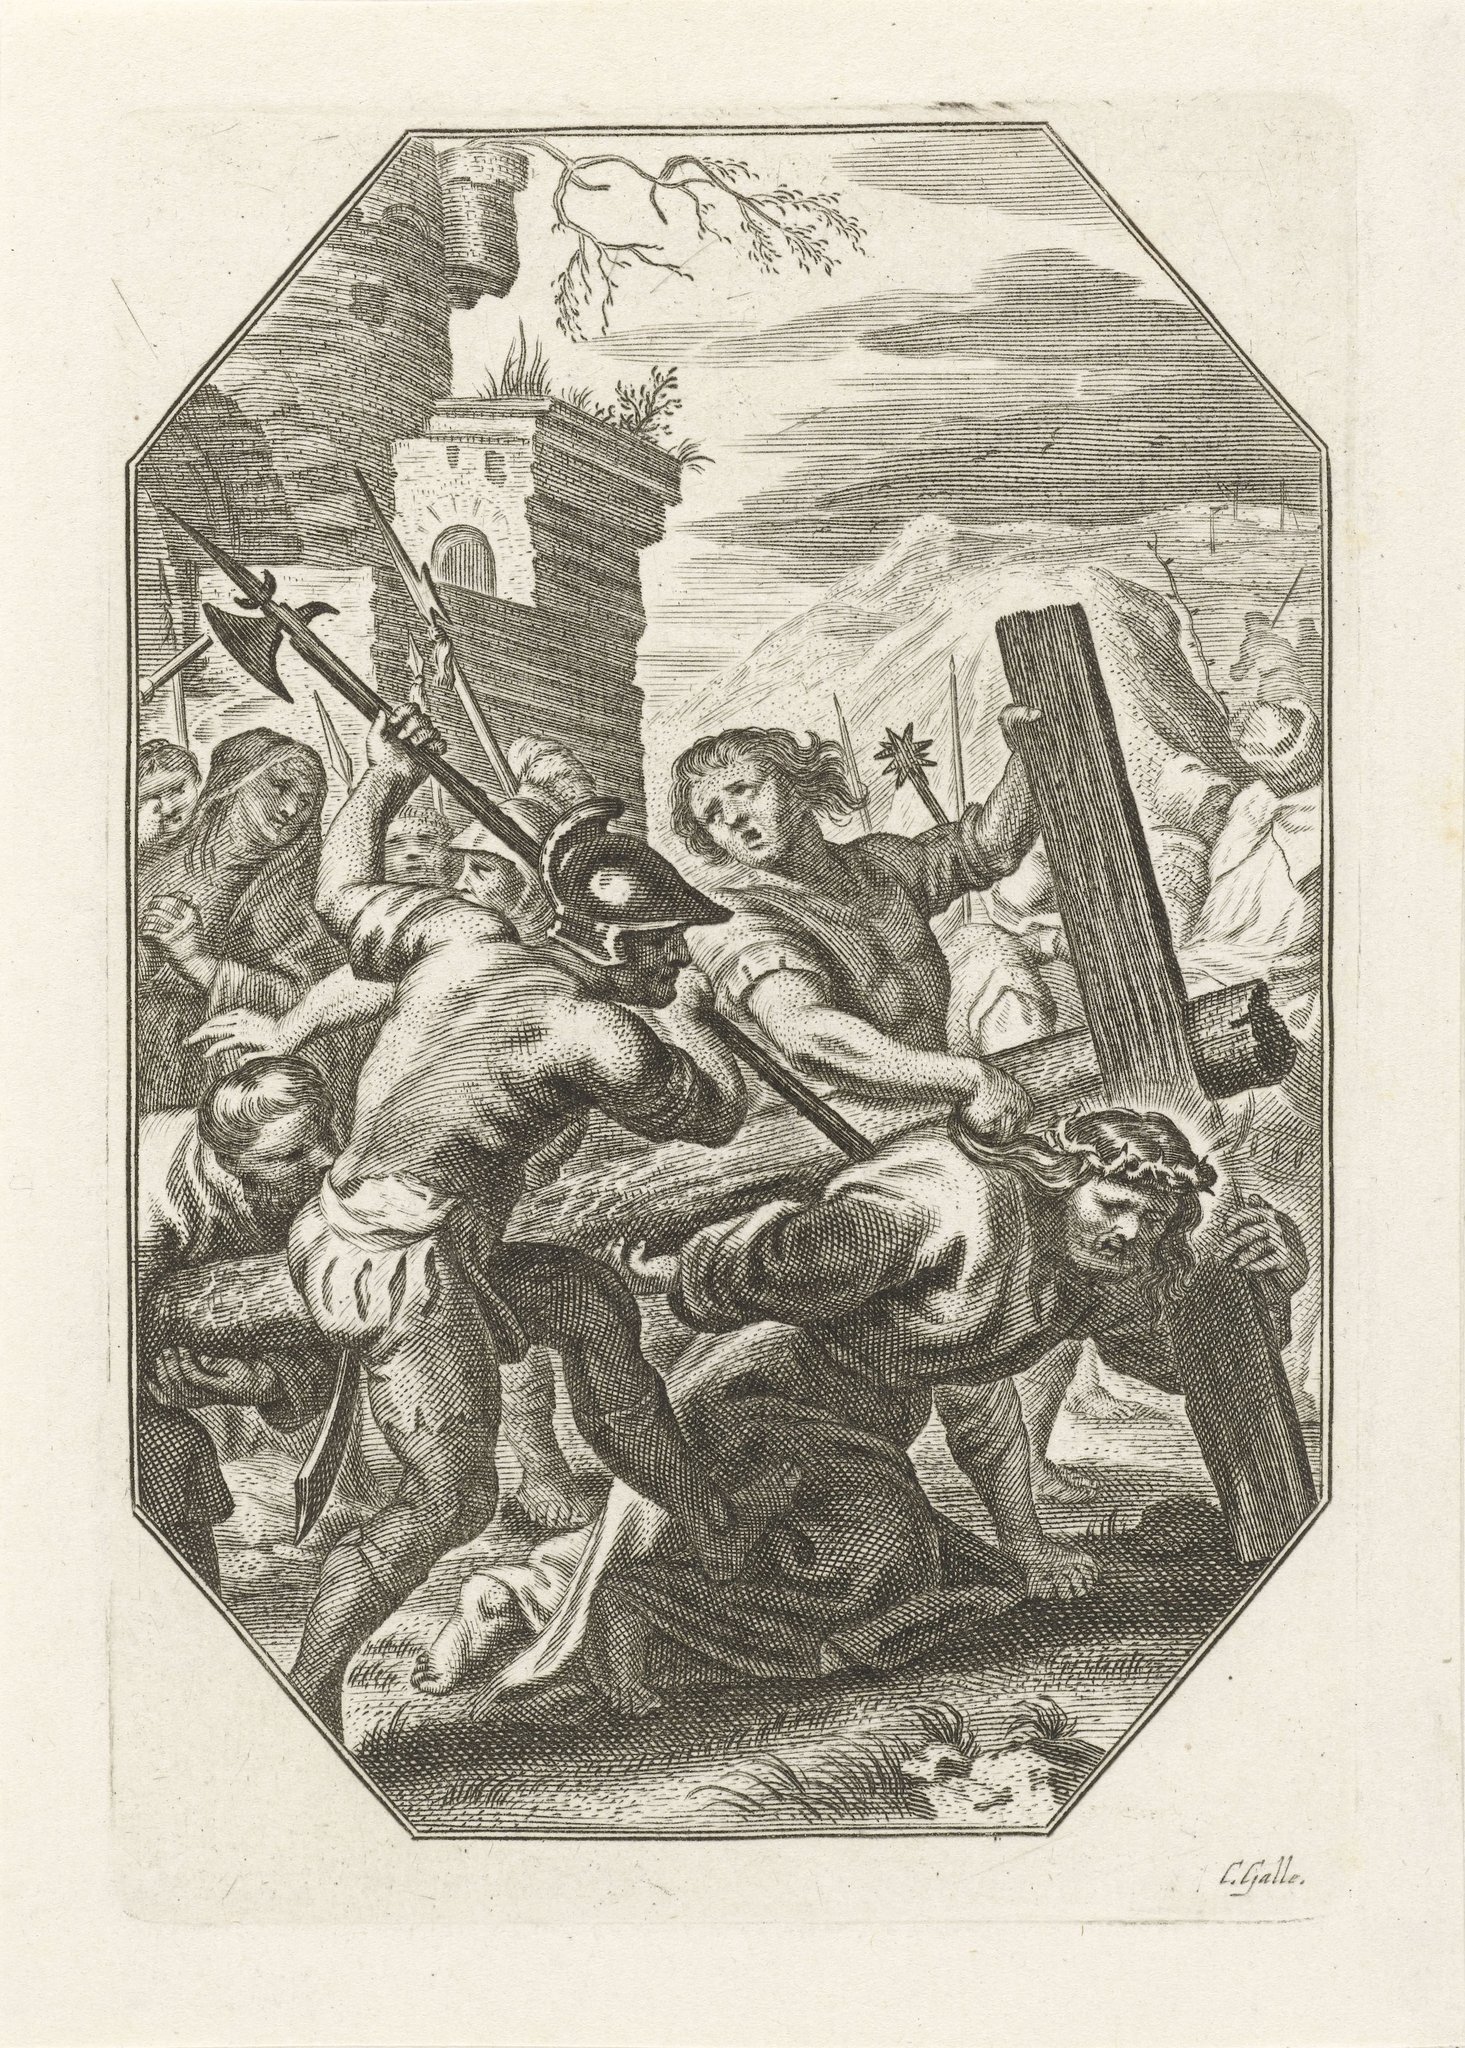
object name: print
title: Kruisdraging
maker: cornelis galle (i)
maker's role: print maker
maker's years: 1576-1650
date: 1586-1650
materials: paper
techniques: engraving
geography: southern netherlands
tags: christ collapsing ~ carrying of the cross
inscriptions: collector's mark: Lugt 2228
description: Christus bezwijmd op weg naar Golgotha onder het gewicht van het kruis en zakt door zijn knieën. Een soldaat duwt hem met een hellebaard in zijn rug. Negende prent uit een serie van 13, met voorstellingen uit het lijdensverhaal van Christus.